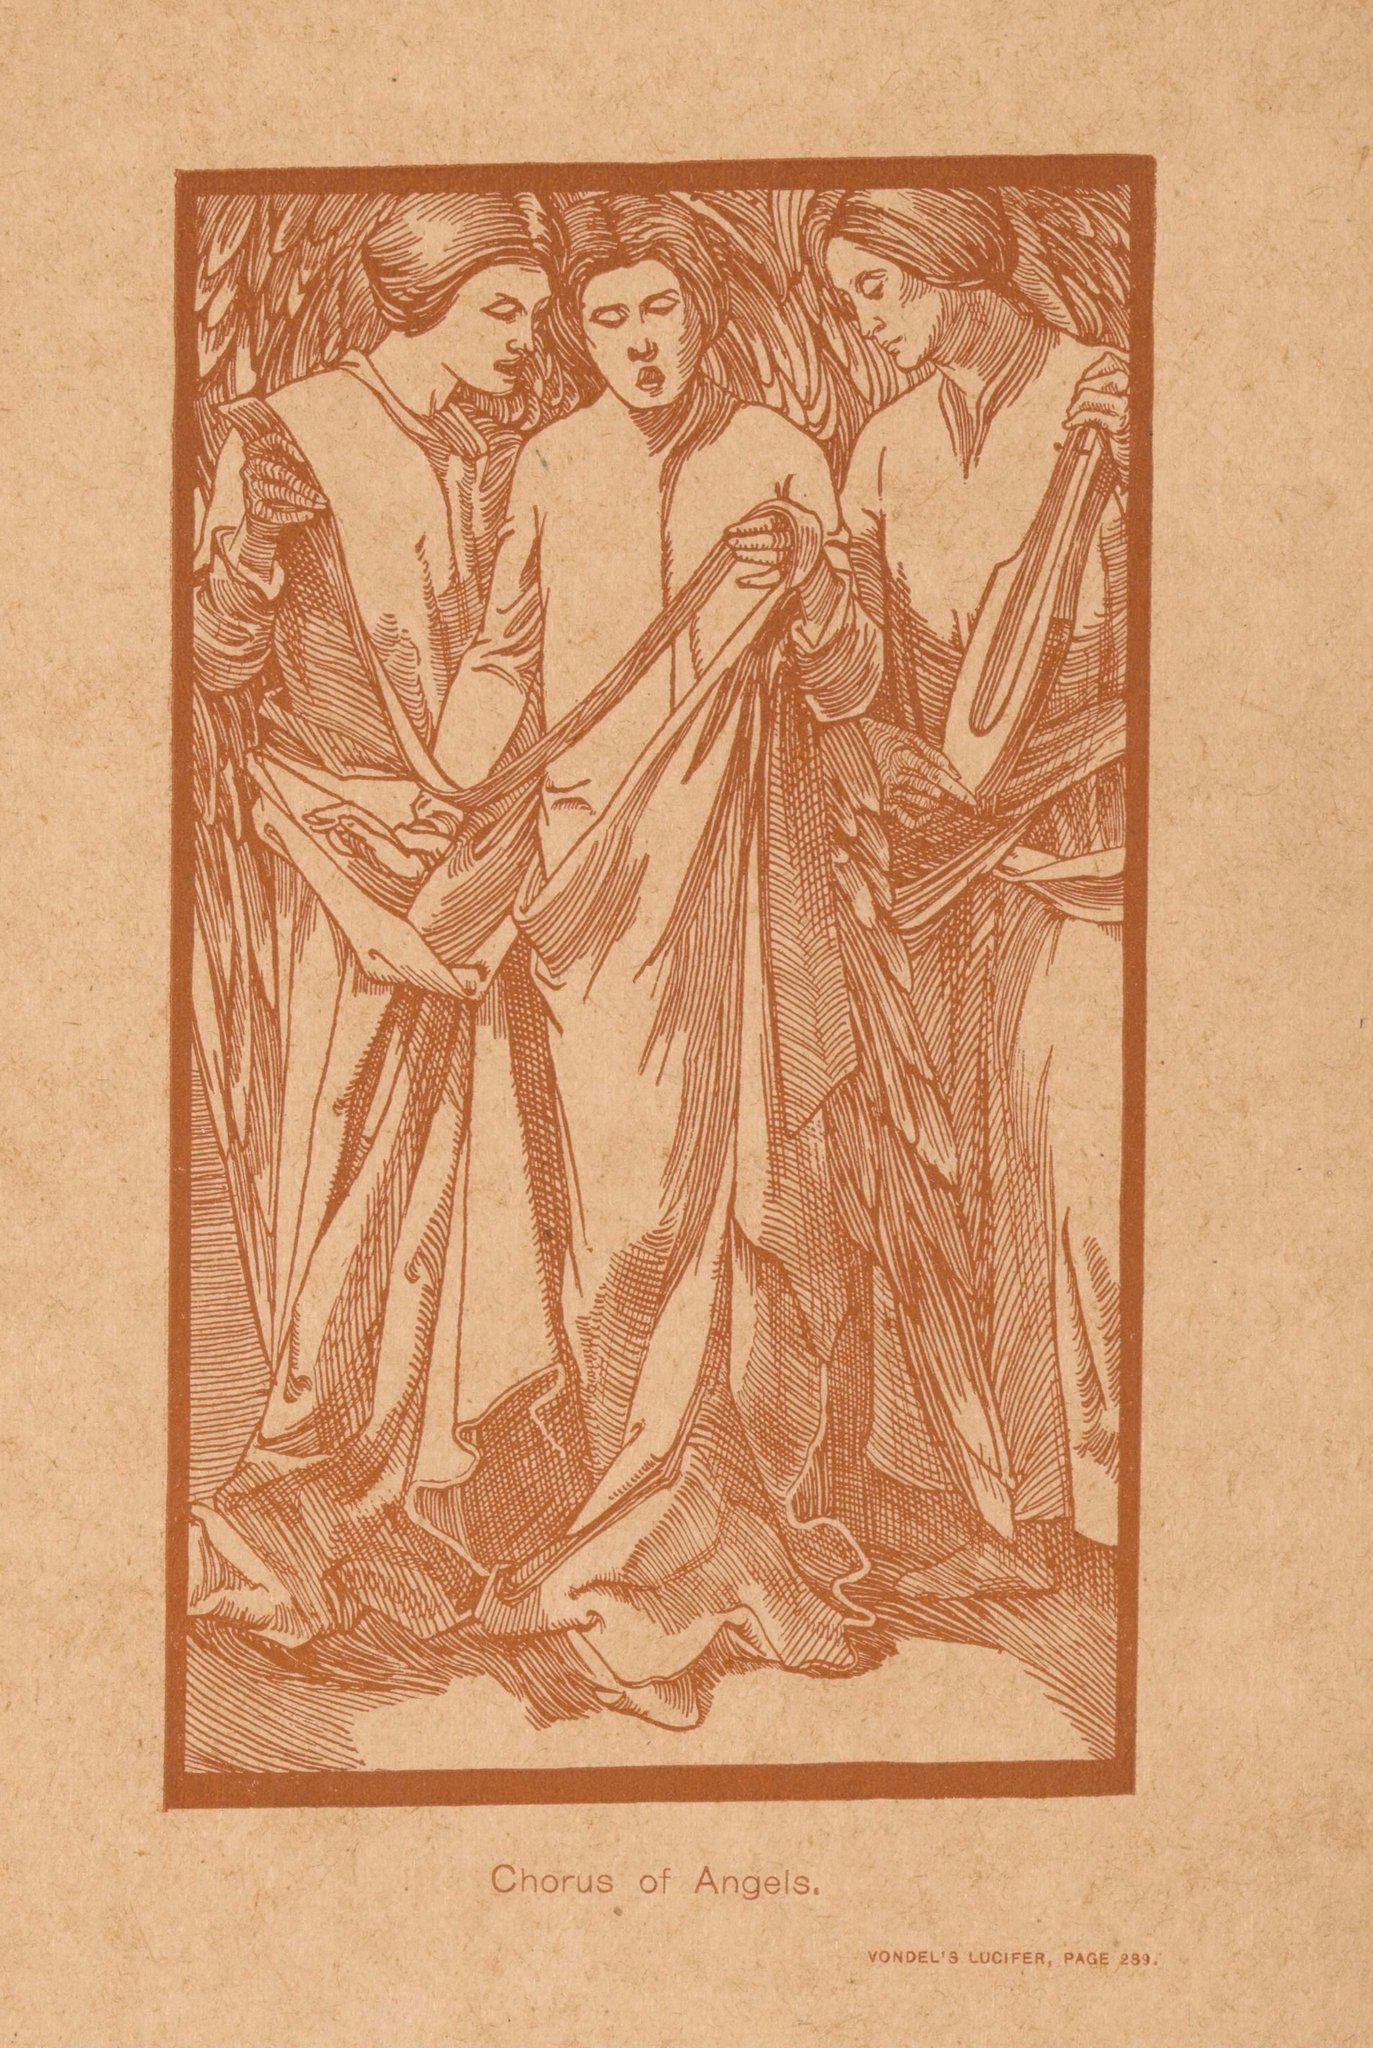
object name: book illustration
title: Engelenkoor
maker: johannes josephus aarts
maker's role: draughtsman, print maker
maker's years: 1871-1934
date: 1898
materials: paper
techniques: letterpress printing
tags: angels singing, making music, string instruments (plucked)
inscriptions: collector's mark: Lugt 2228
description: Prent gebruikt voor: Vondel, Joost van den. Lucifer. [Vertaald uit het Nederlands door] Leonard Charles van Noppen. New York en Londen: Continental Publishing Co., 1898.